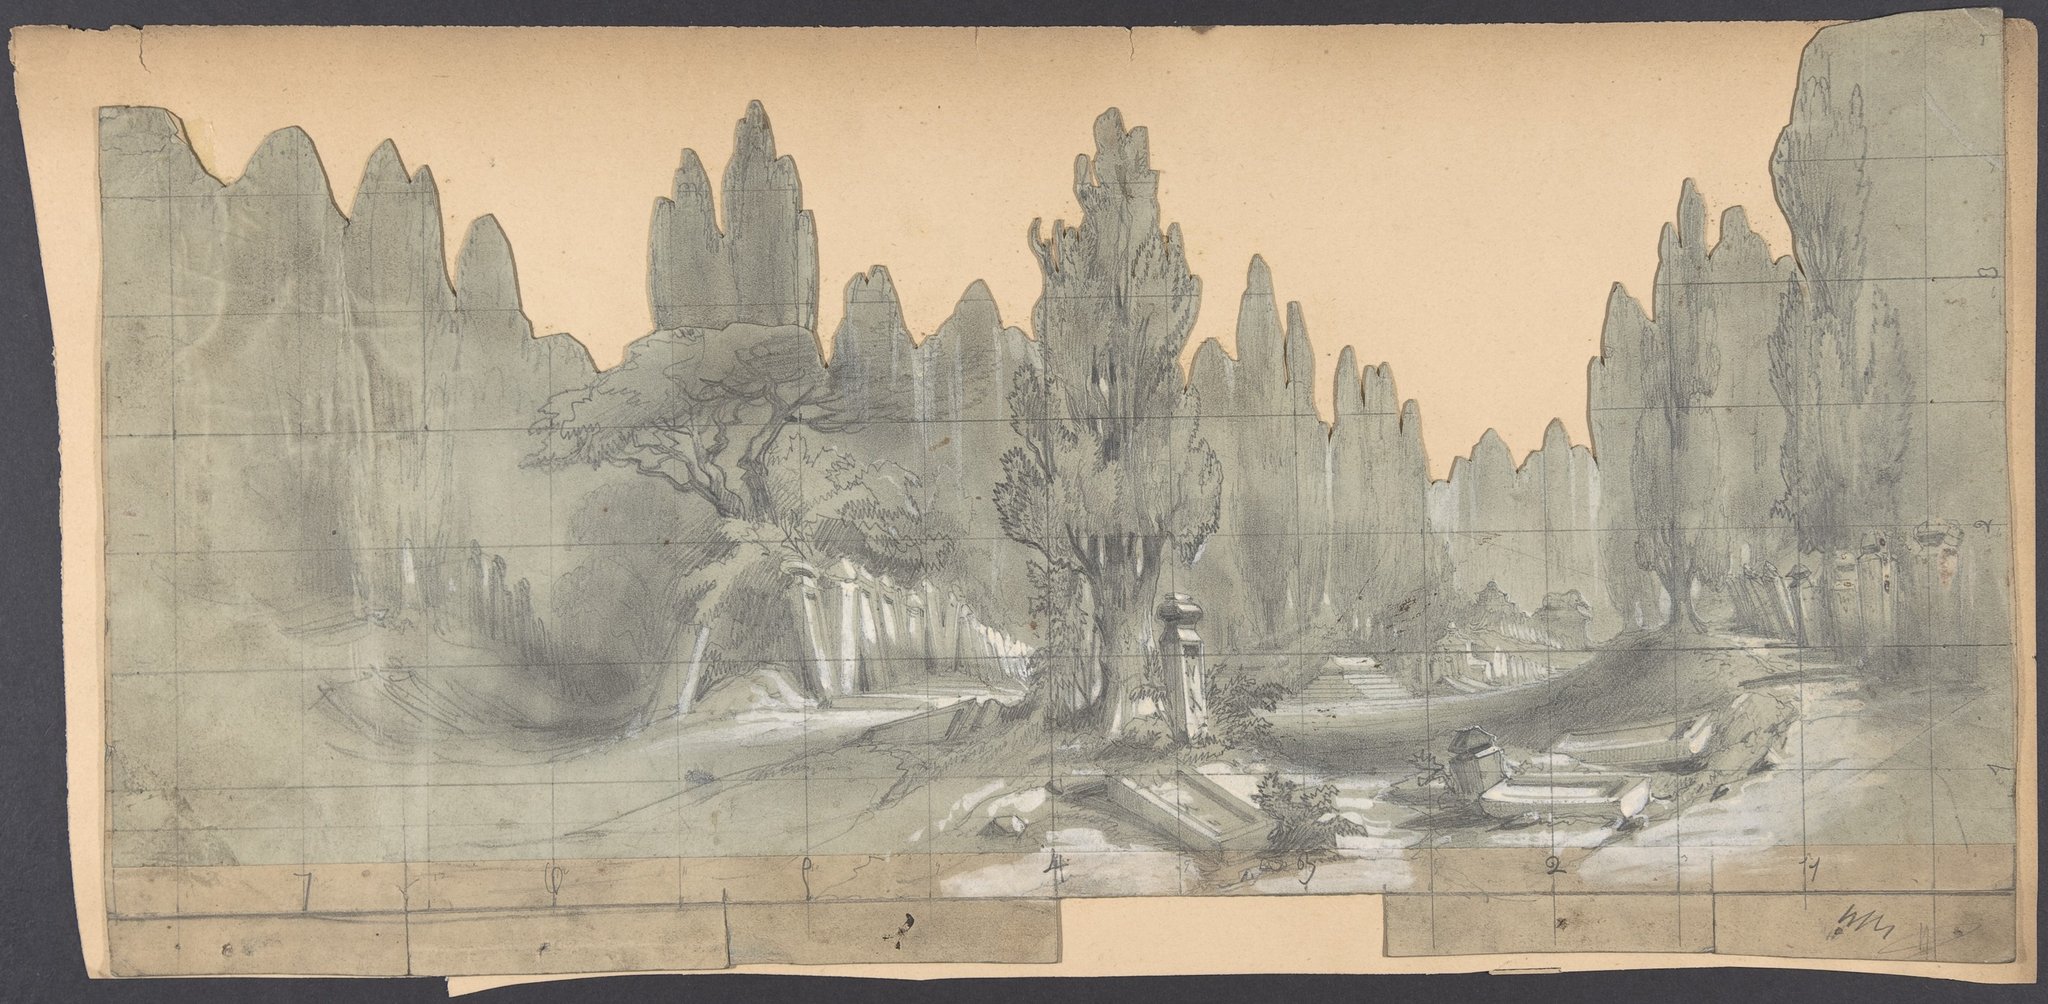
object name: drawing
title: Design for a Stage Set at the Opéra, Paris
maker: eugène cicéri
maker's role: artist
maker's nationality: french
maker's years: 1813-1890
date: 1825-1890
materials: graphite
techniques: heightening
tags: trees,stage design